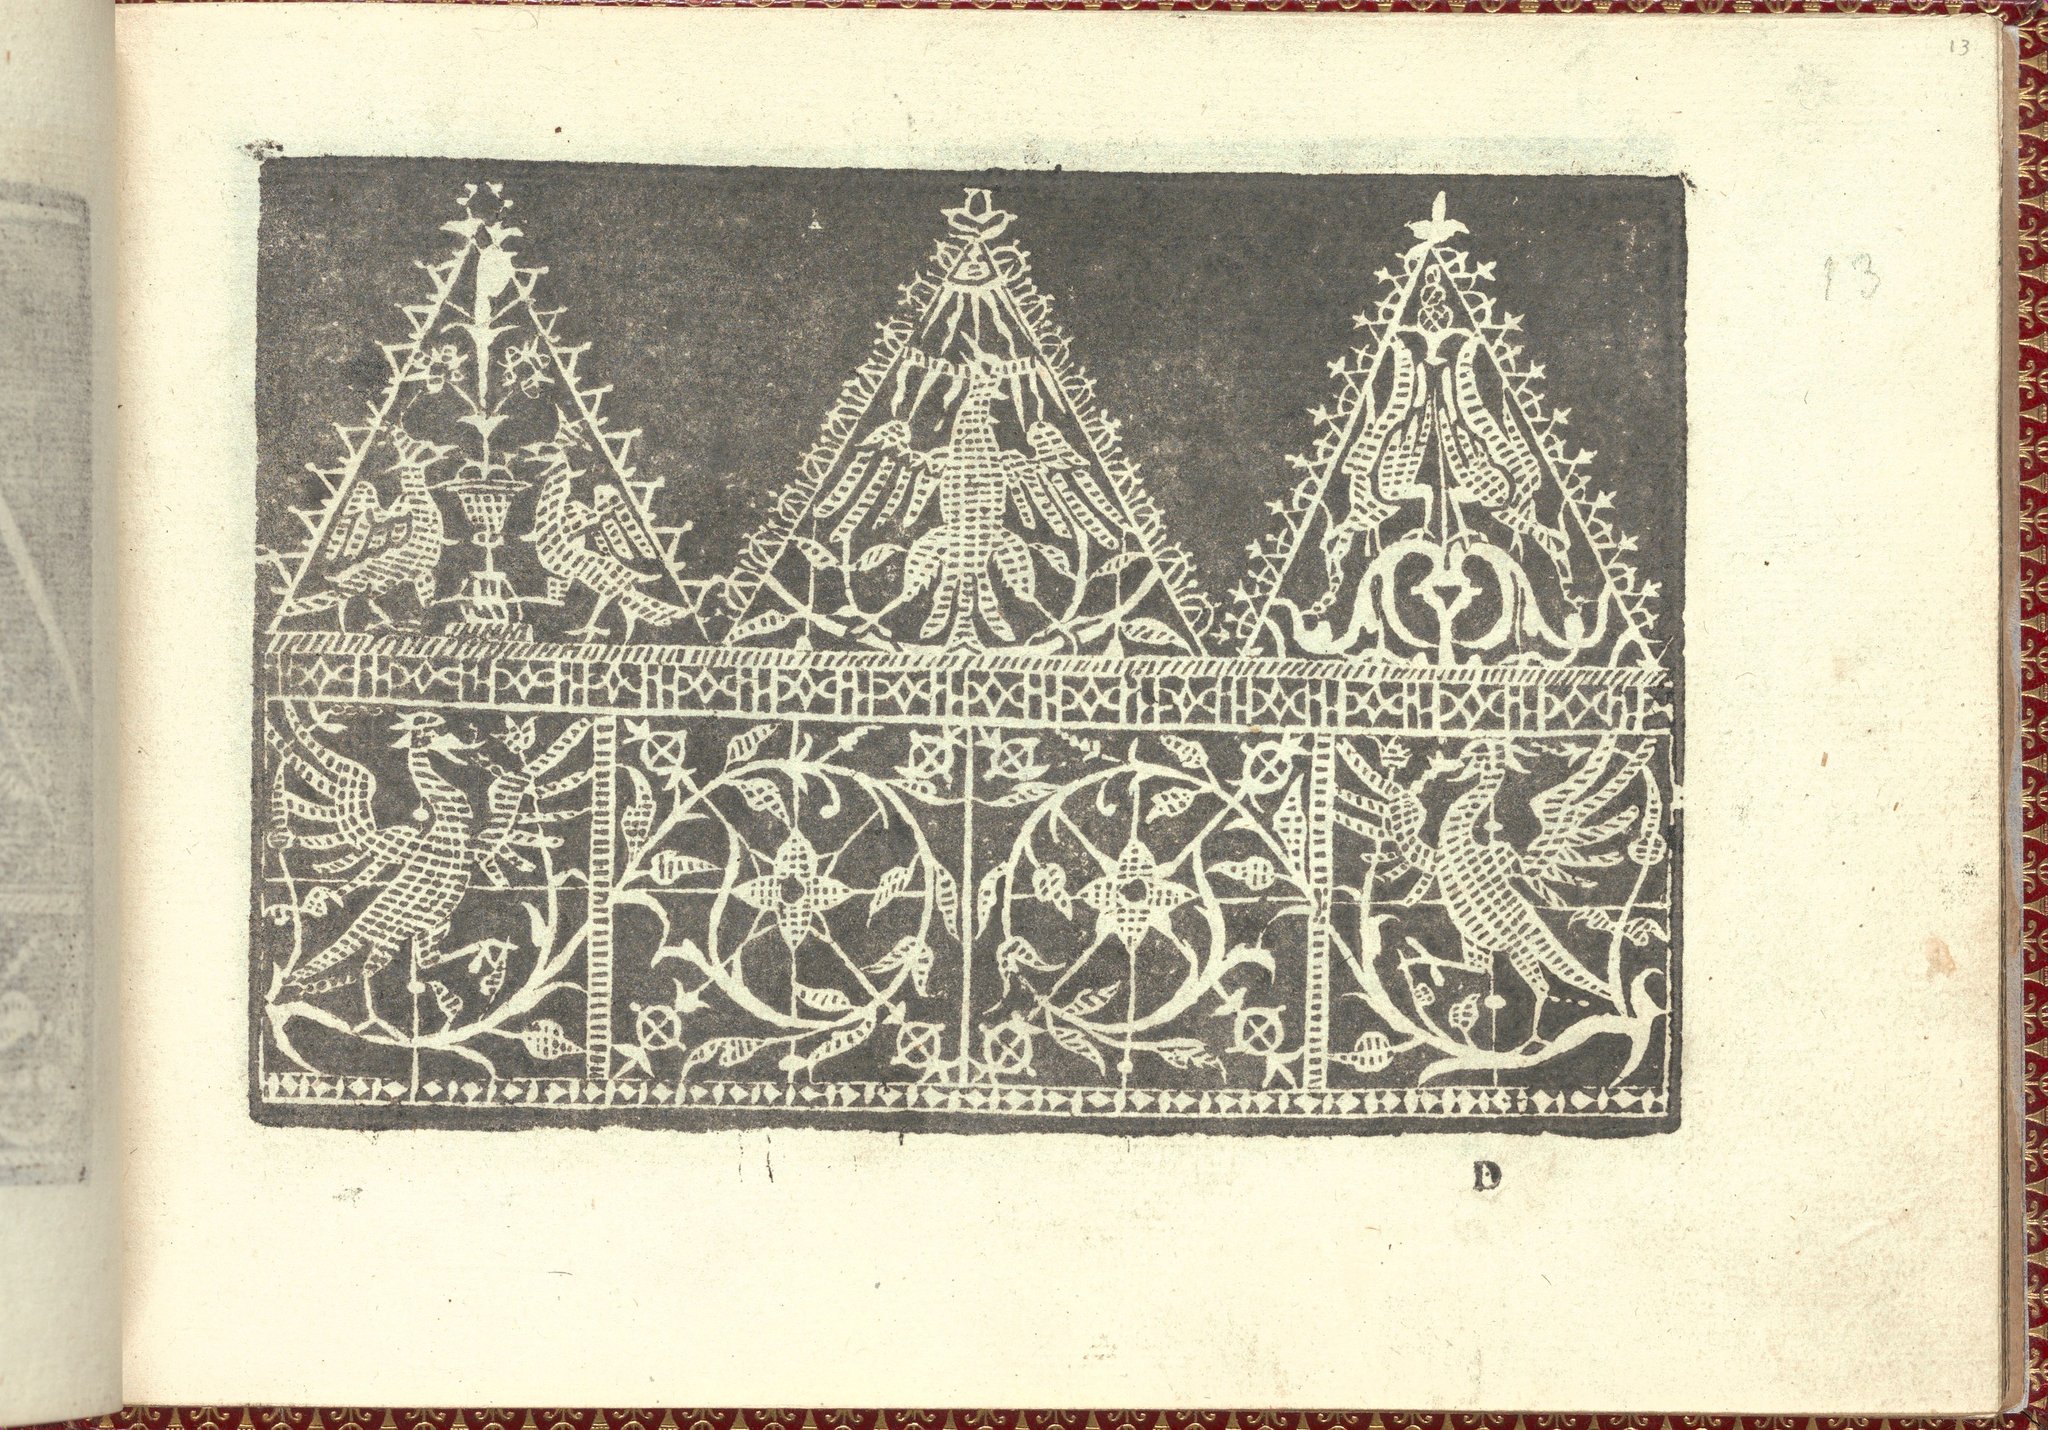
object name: book print ornament architecture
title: Corona delle Nobili et Virtuose Donne: Libro I-IV, page 13 (recto)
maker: cesare vecellio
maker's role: publisher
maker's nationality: italian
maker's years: 1521-1601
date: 1601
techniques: woodcut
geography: italy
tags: birds